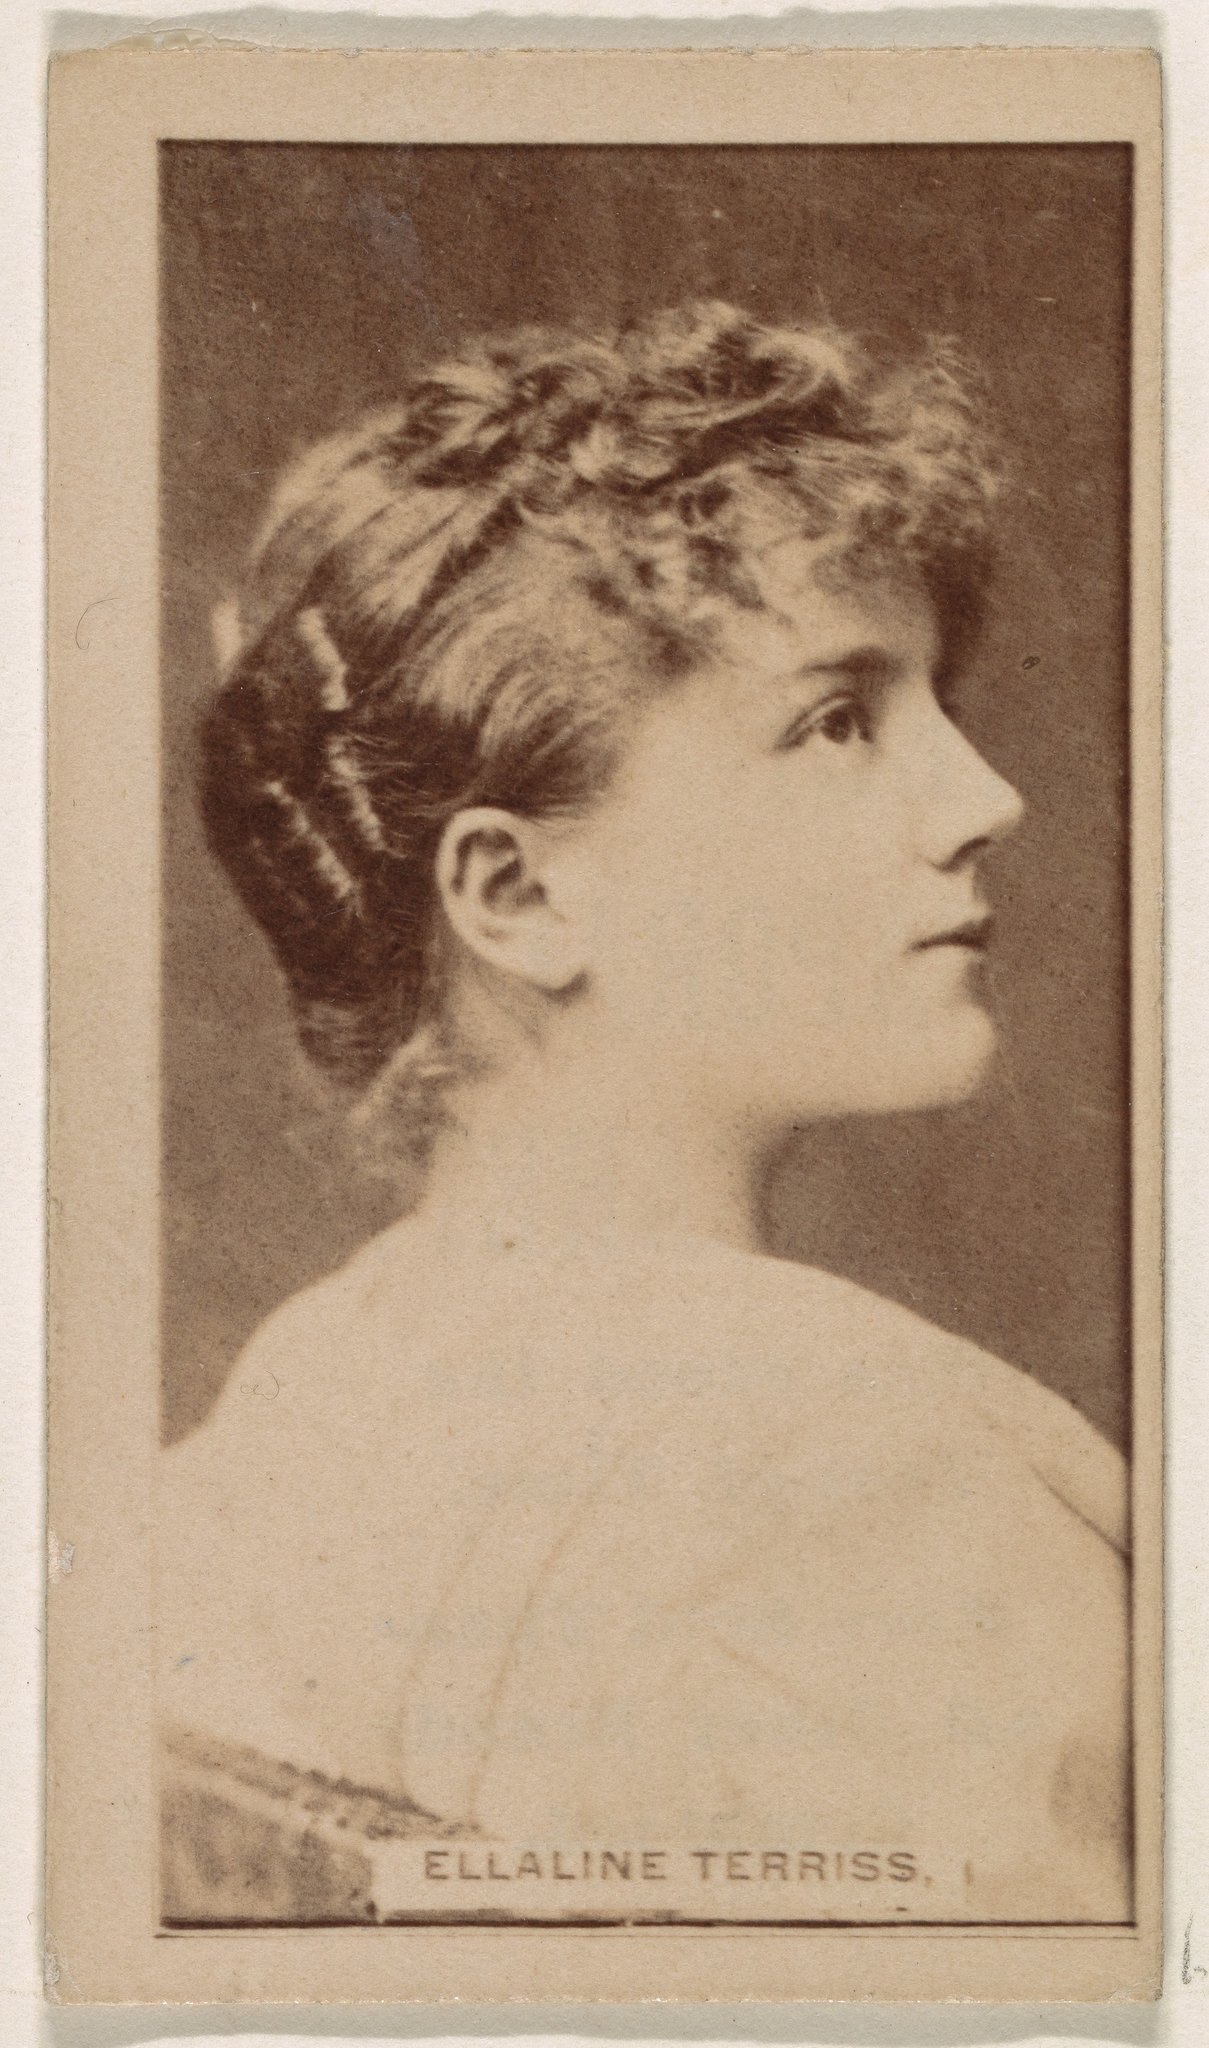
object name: photograph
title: Ellaline Terriss, from the Actresses series (N245) issued by Kinney Brothers to promote Sweet Caporal Cigarettes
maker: kinney brothers tobacco company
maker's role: publisher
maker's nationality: american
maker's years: 1869-2011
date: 1890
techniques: albumen silver print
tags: women,actresses